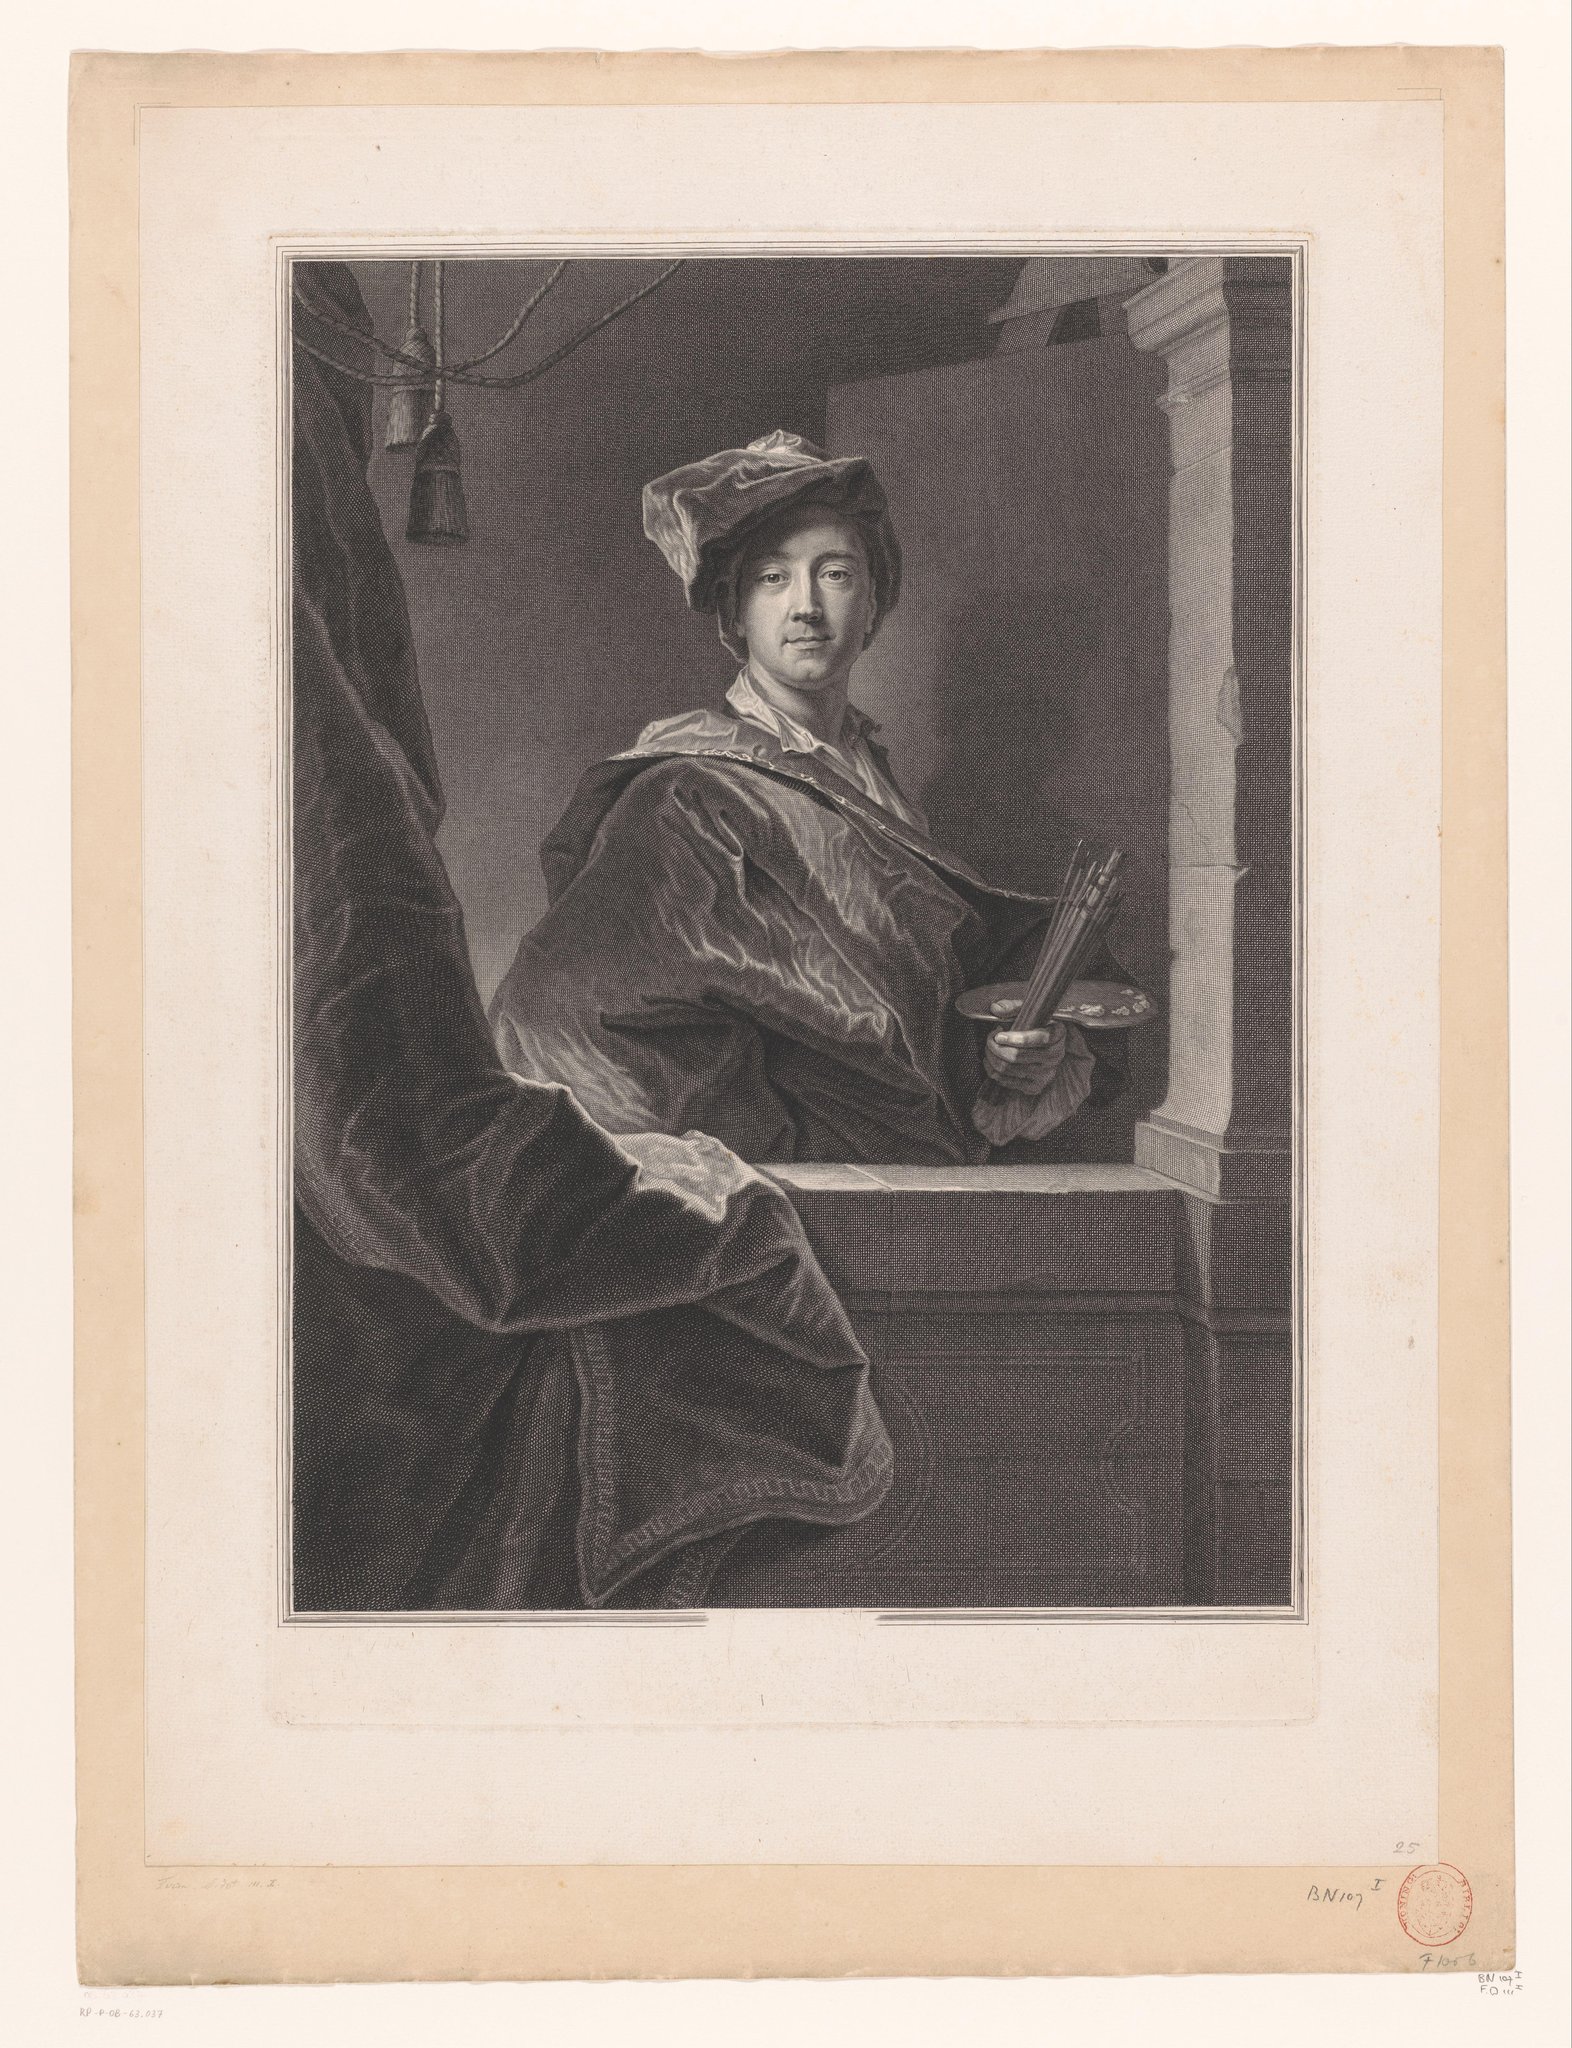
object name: print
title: Hyacinthe Rigaud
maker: pierre drevet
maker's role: print maker, publisher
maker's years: 1663-1738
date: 1714-1721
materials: paper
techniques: engraving, etching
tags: draughtsman, hyacinthe rigaud, historical persons, portrait, self-portrait of painter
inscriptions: collector's mark: Lugt 240